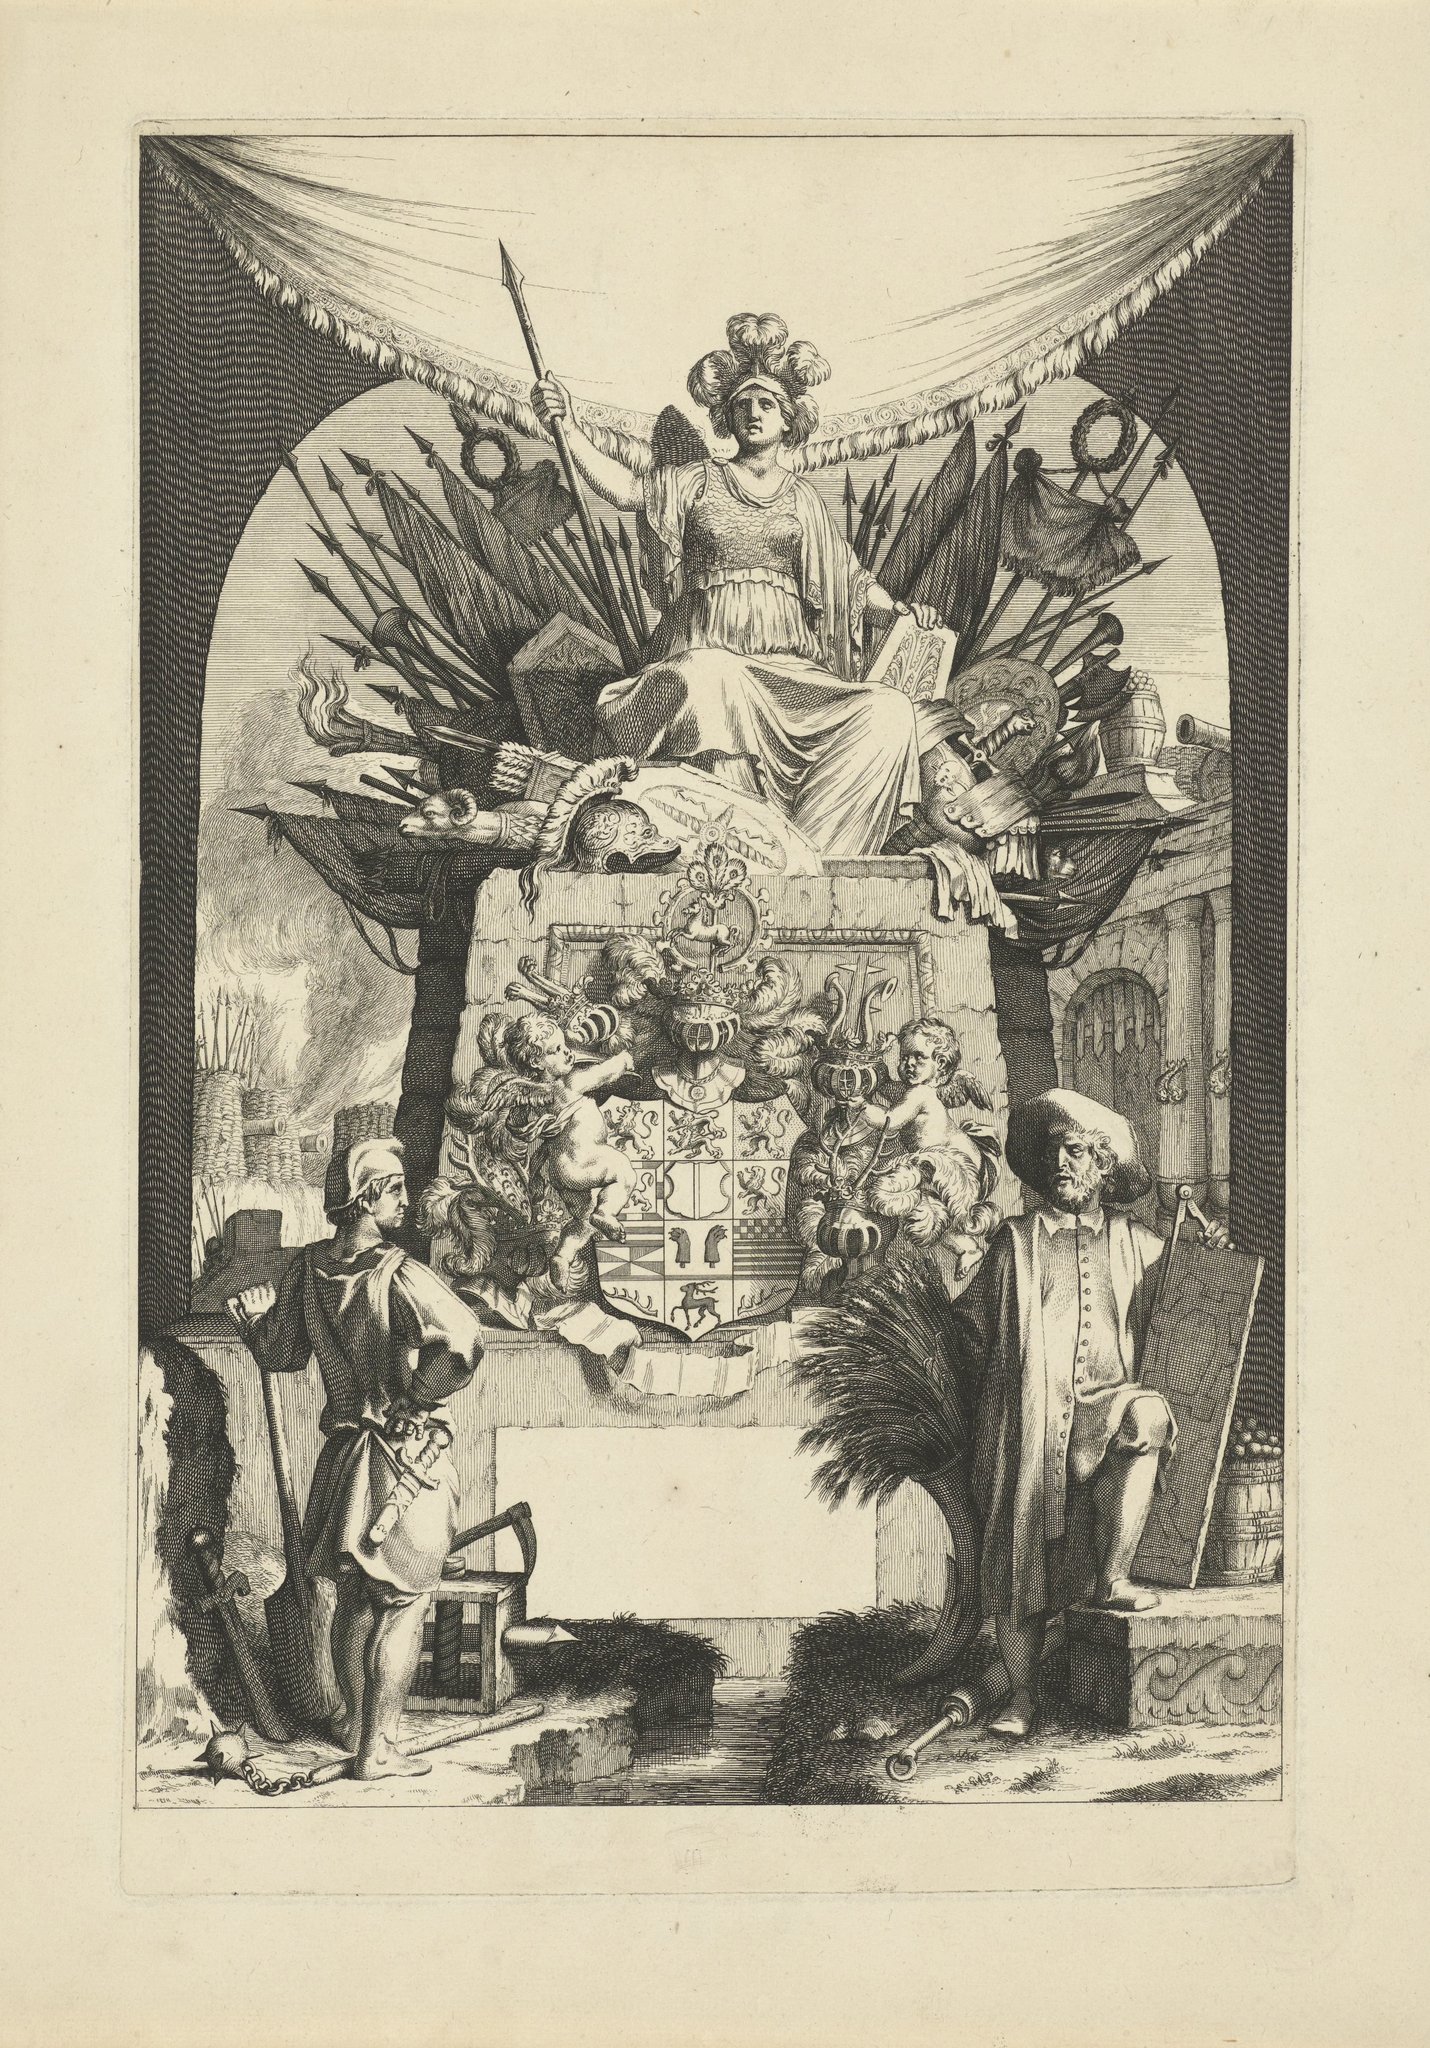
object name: print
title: Minerva tronend boven een wapenschild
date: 1600-1699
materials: paper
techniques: etching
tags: building activities (+ plan, design ~ production), (story of) minerva (pallas, athena), tools, implements of craftsman, armorial bearing, heraldry, tools, implements of architect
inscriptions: collector's mark: Lugt 240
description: Minerva troont op een voetstuk dat versierd is met een wapenschild. Op de voorgrond staan twee figuren. De figuur links is omringd met gereedschap, rechts staat een tweede figuur met een passer, bouwtekening en een hoorn gevuld met koren. Links op de achtergrond worden kanonnen afgeschoten.